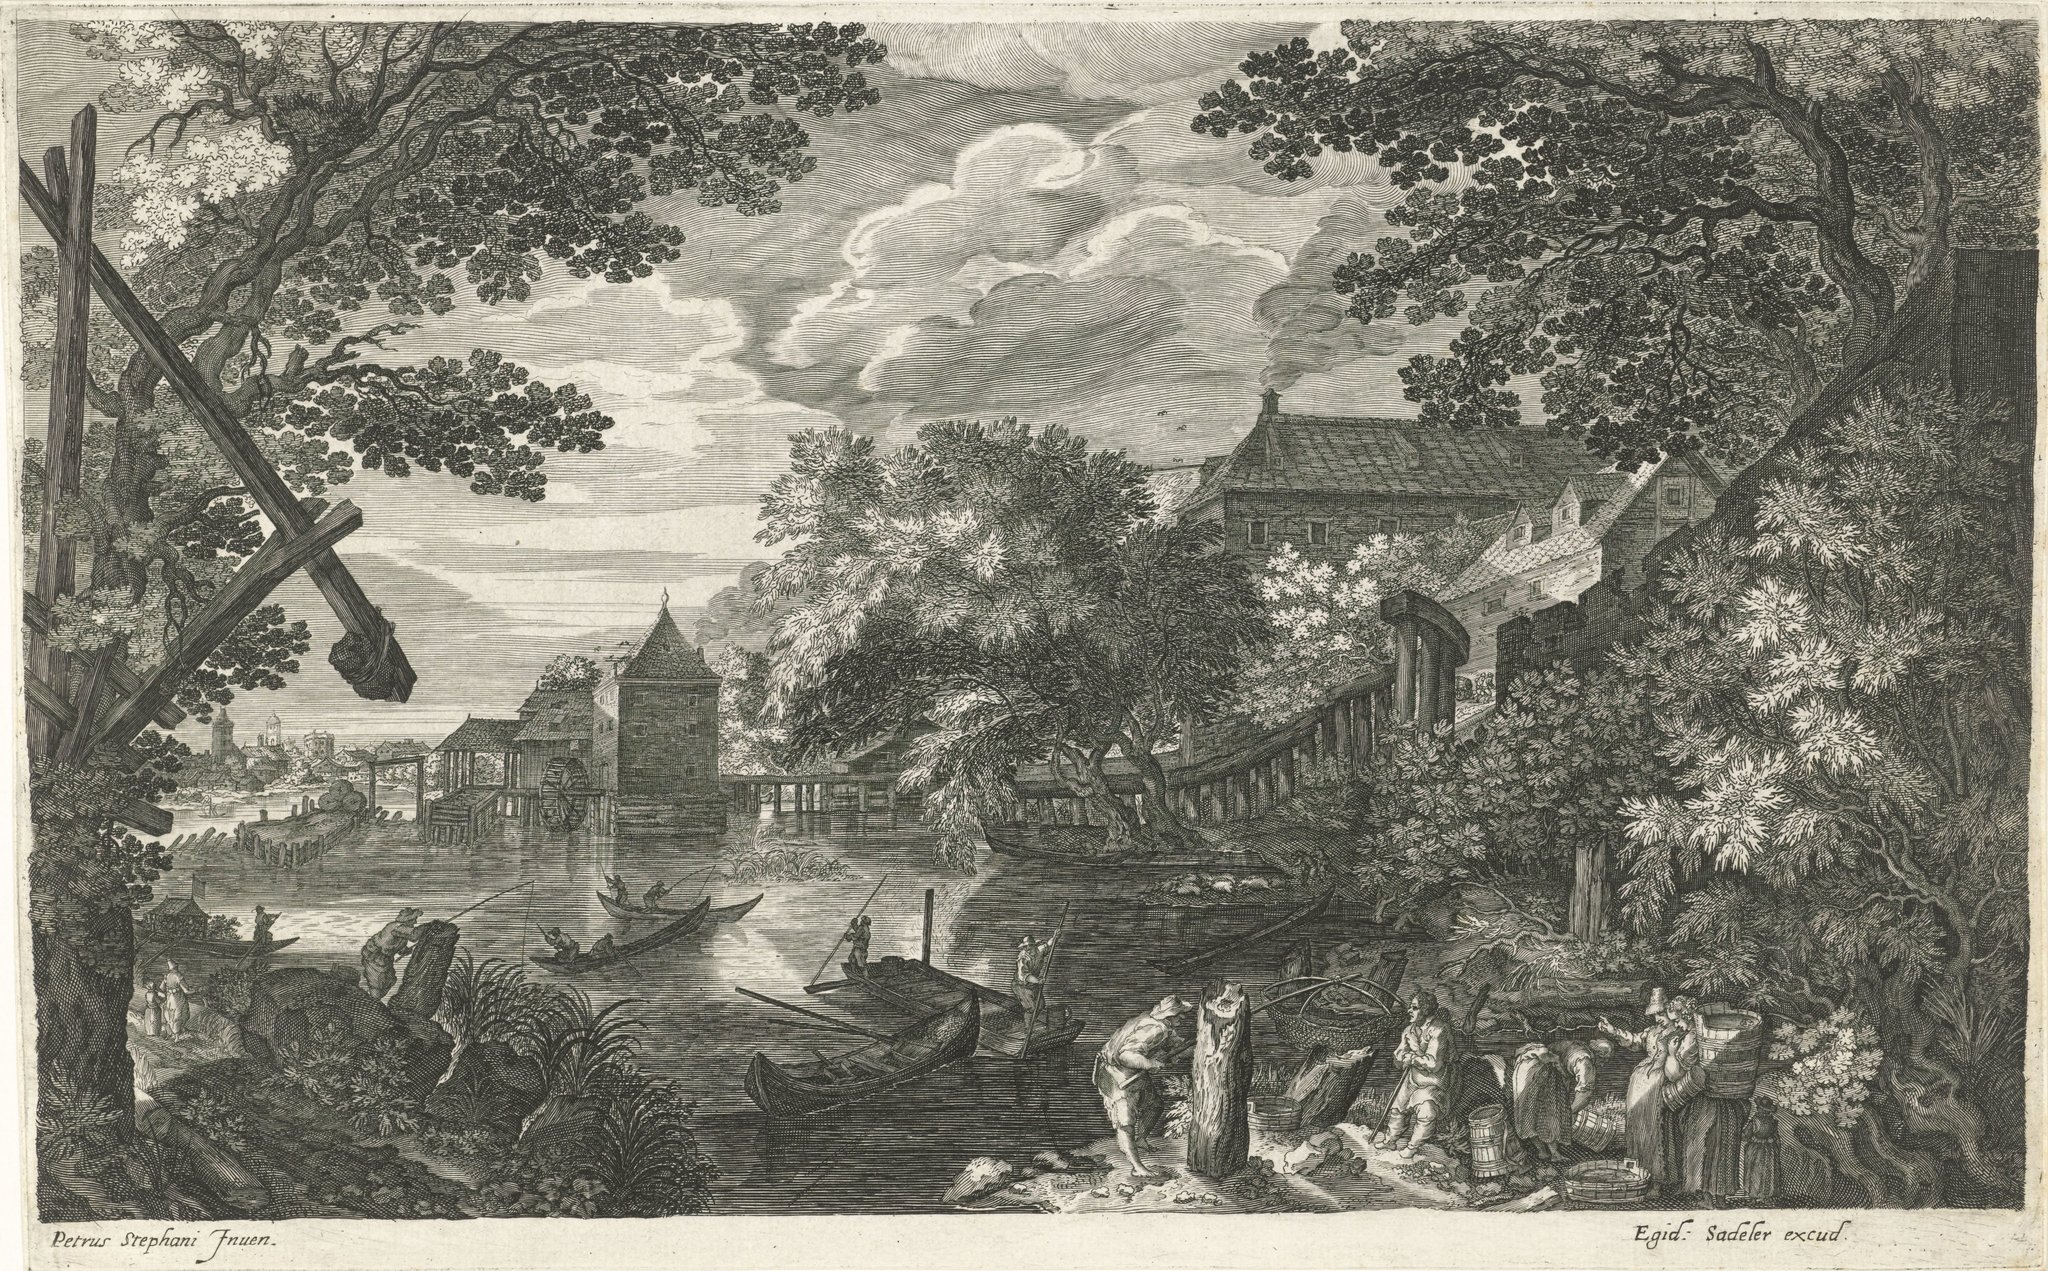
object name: print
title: Acht landschappen in Bohemen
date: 1597-1629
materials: paper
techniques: engraving, etching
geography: prague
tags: commercial fishery, watermill in landscape, river (+ landscape with figures, staffage)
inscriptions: collector's mark: Lugt 240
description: Een rivier met aan de oever hengelaars en werklieden. Op de achtergrond een watermolen. De zesde prent van een achtdelige reeks met landschappen in Bohemen